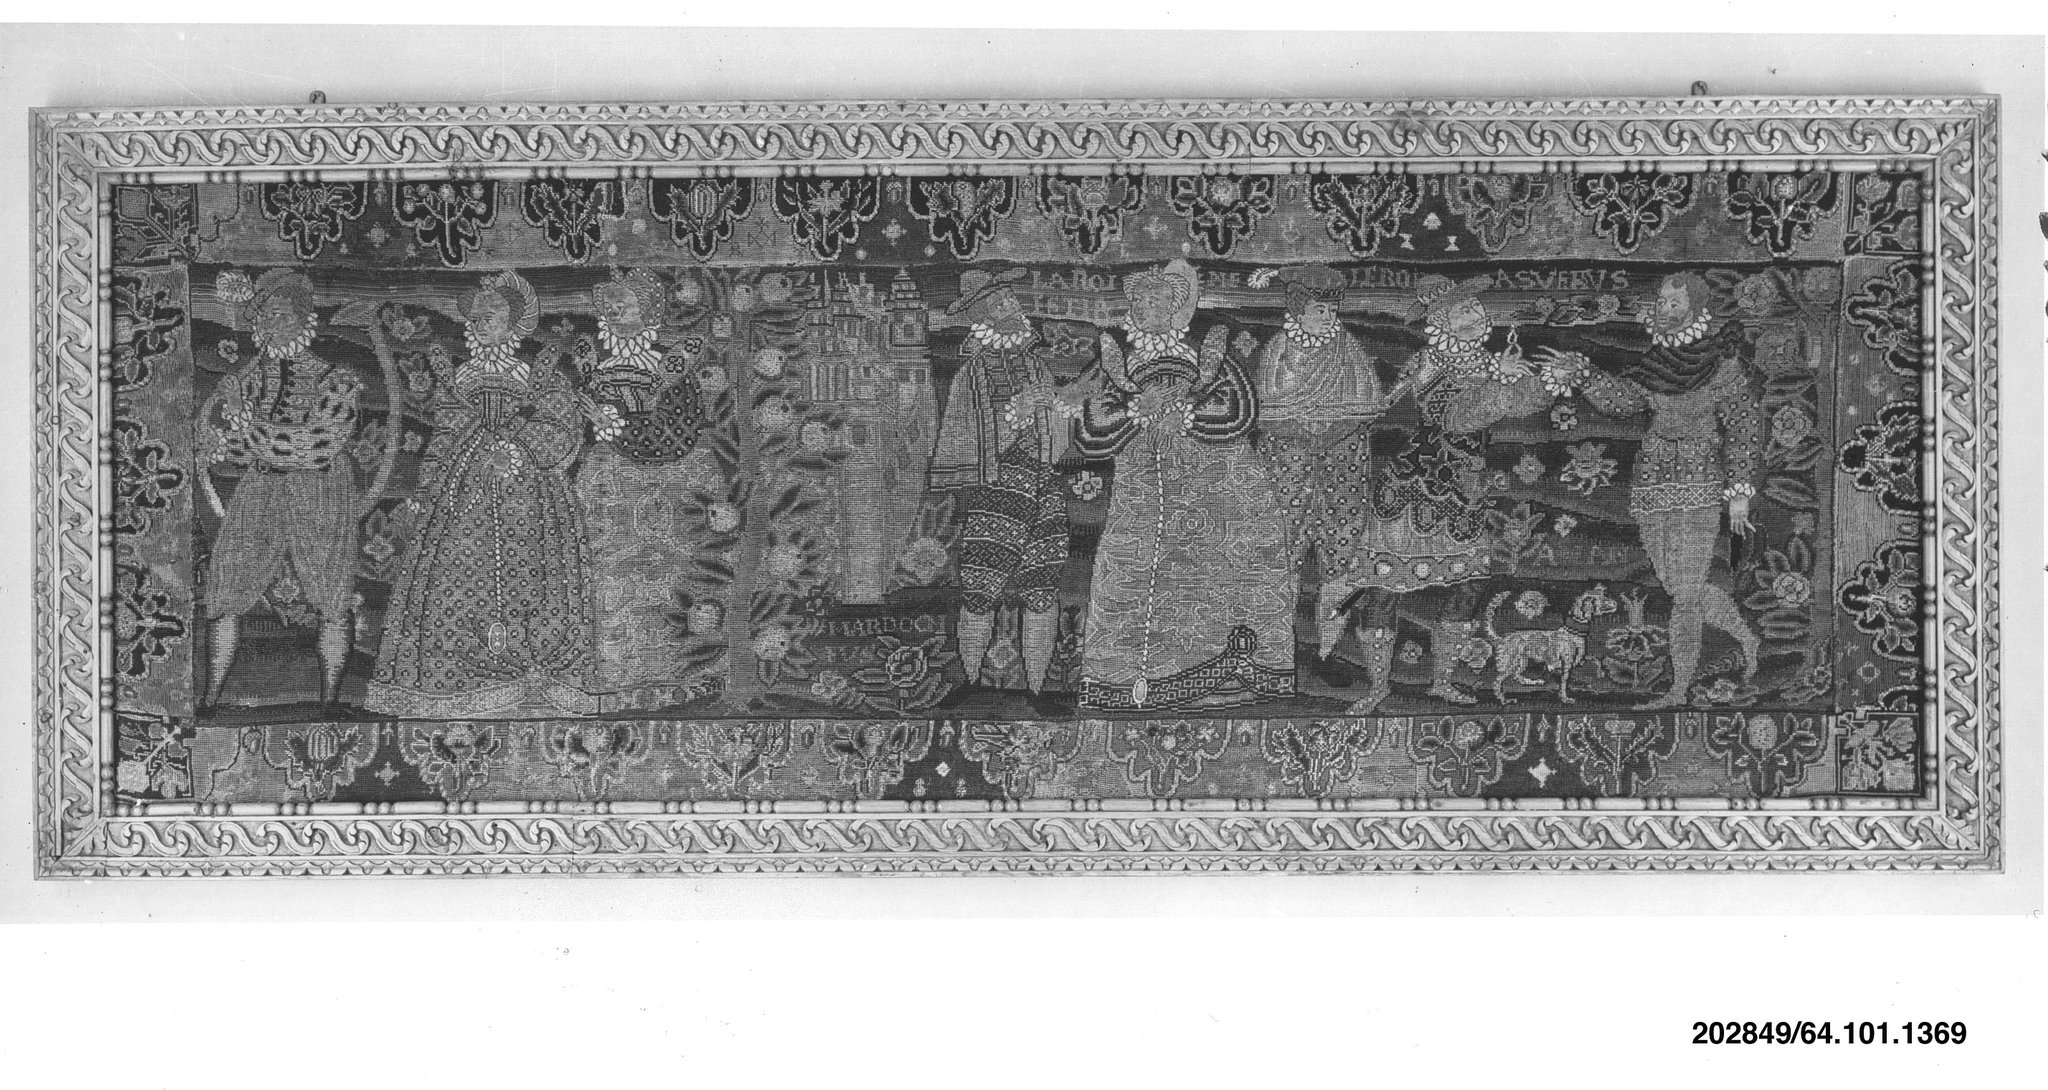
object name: panel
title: Esther and Ahasuerus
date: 1600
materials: canvas, silk, wool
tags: dogs,esther,ahasuerus